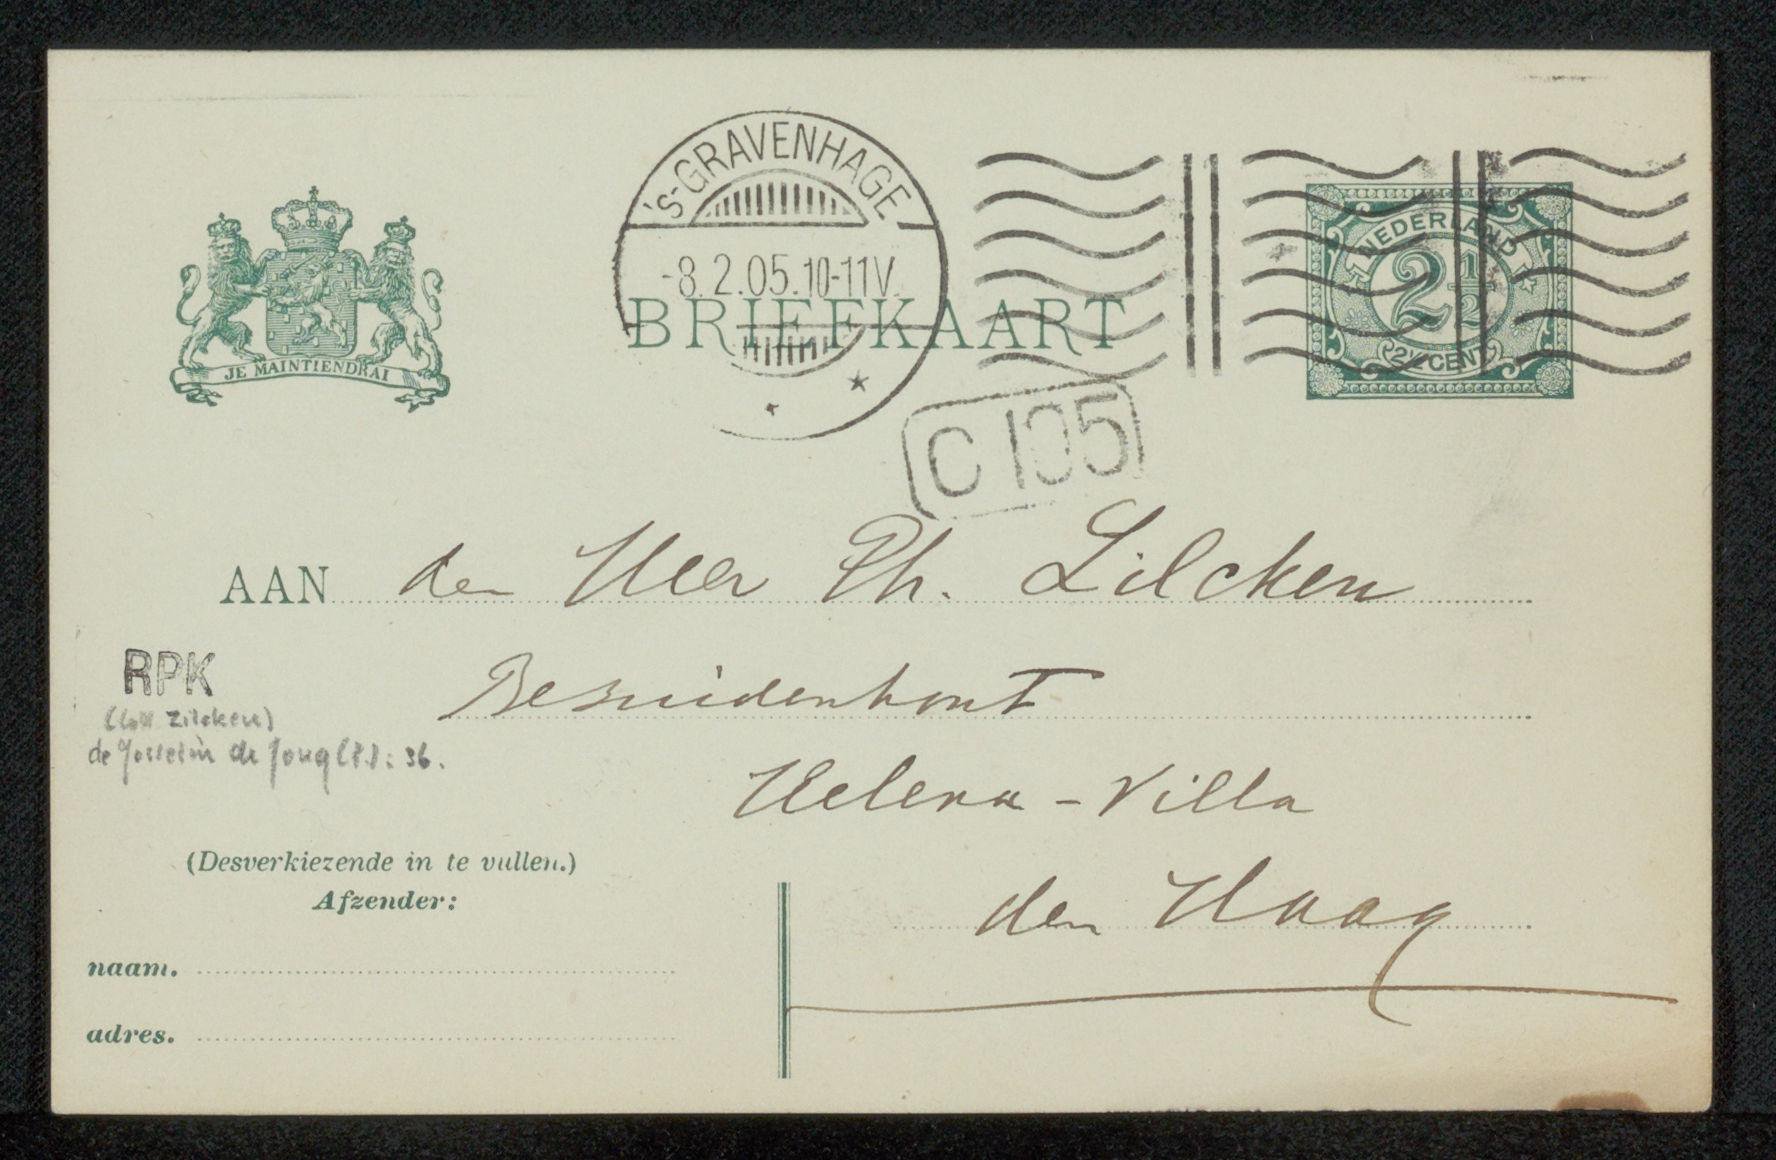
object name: postcard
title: Briefkaart aan Philip Zilcken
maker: pieter de josselin de jong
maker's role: draughtsman, painter, print maker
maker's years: 1861-1906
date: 1905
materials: cardboard, ink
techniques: writing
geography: the hague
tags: the hague, philip zilcken, the graphic arts, temporary exhibition, 'salon', venice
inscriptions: collector's mark: ‘RPK’